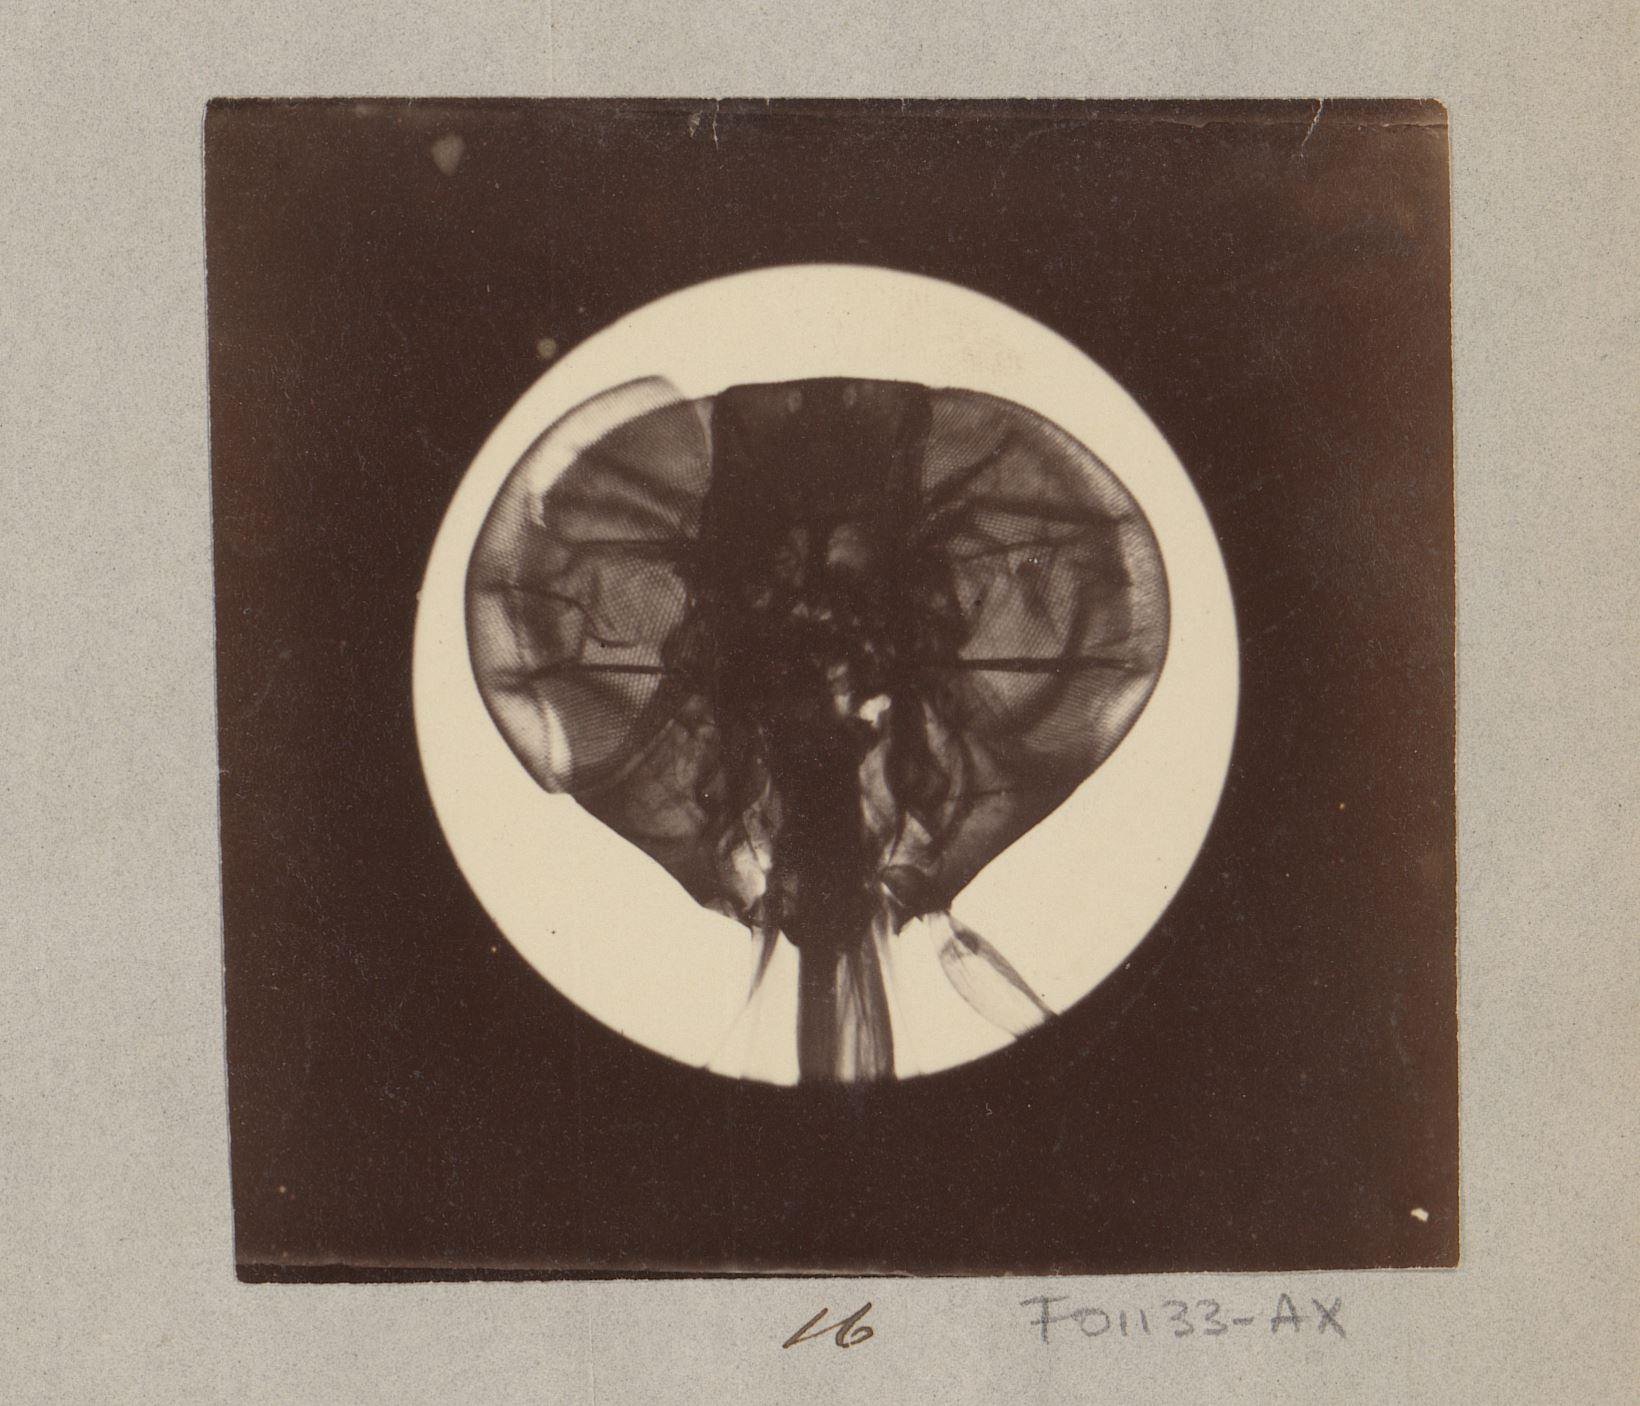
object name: photograph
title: Microscopische opname van kop van een vlieg, 25 keer vergroot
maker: marinus pieter filbri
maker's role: instrument maker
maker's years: 1852-1917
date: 1887-1888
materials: paper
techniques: albumen print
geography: netherlands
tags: insects: fly, netherlands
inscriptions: inscription: ‘No. 16. Benaming Kop eener vlieg, 25 x vergroot, pose 4 min., bemerking Lomb.’, number: ‘16’